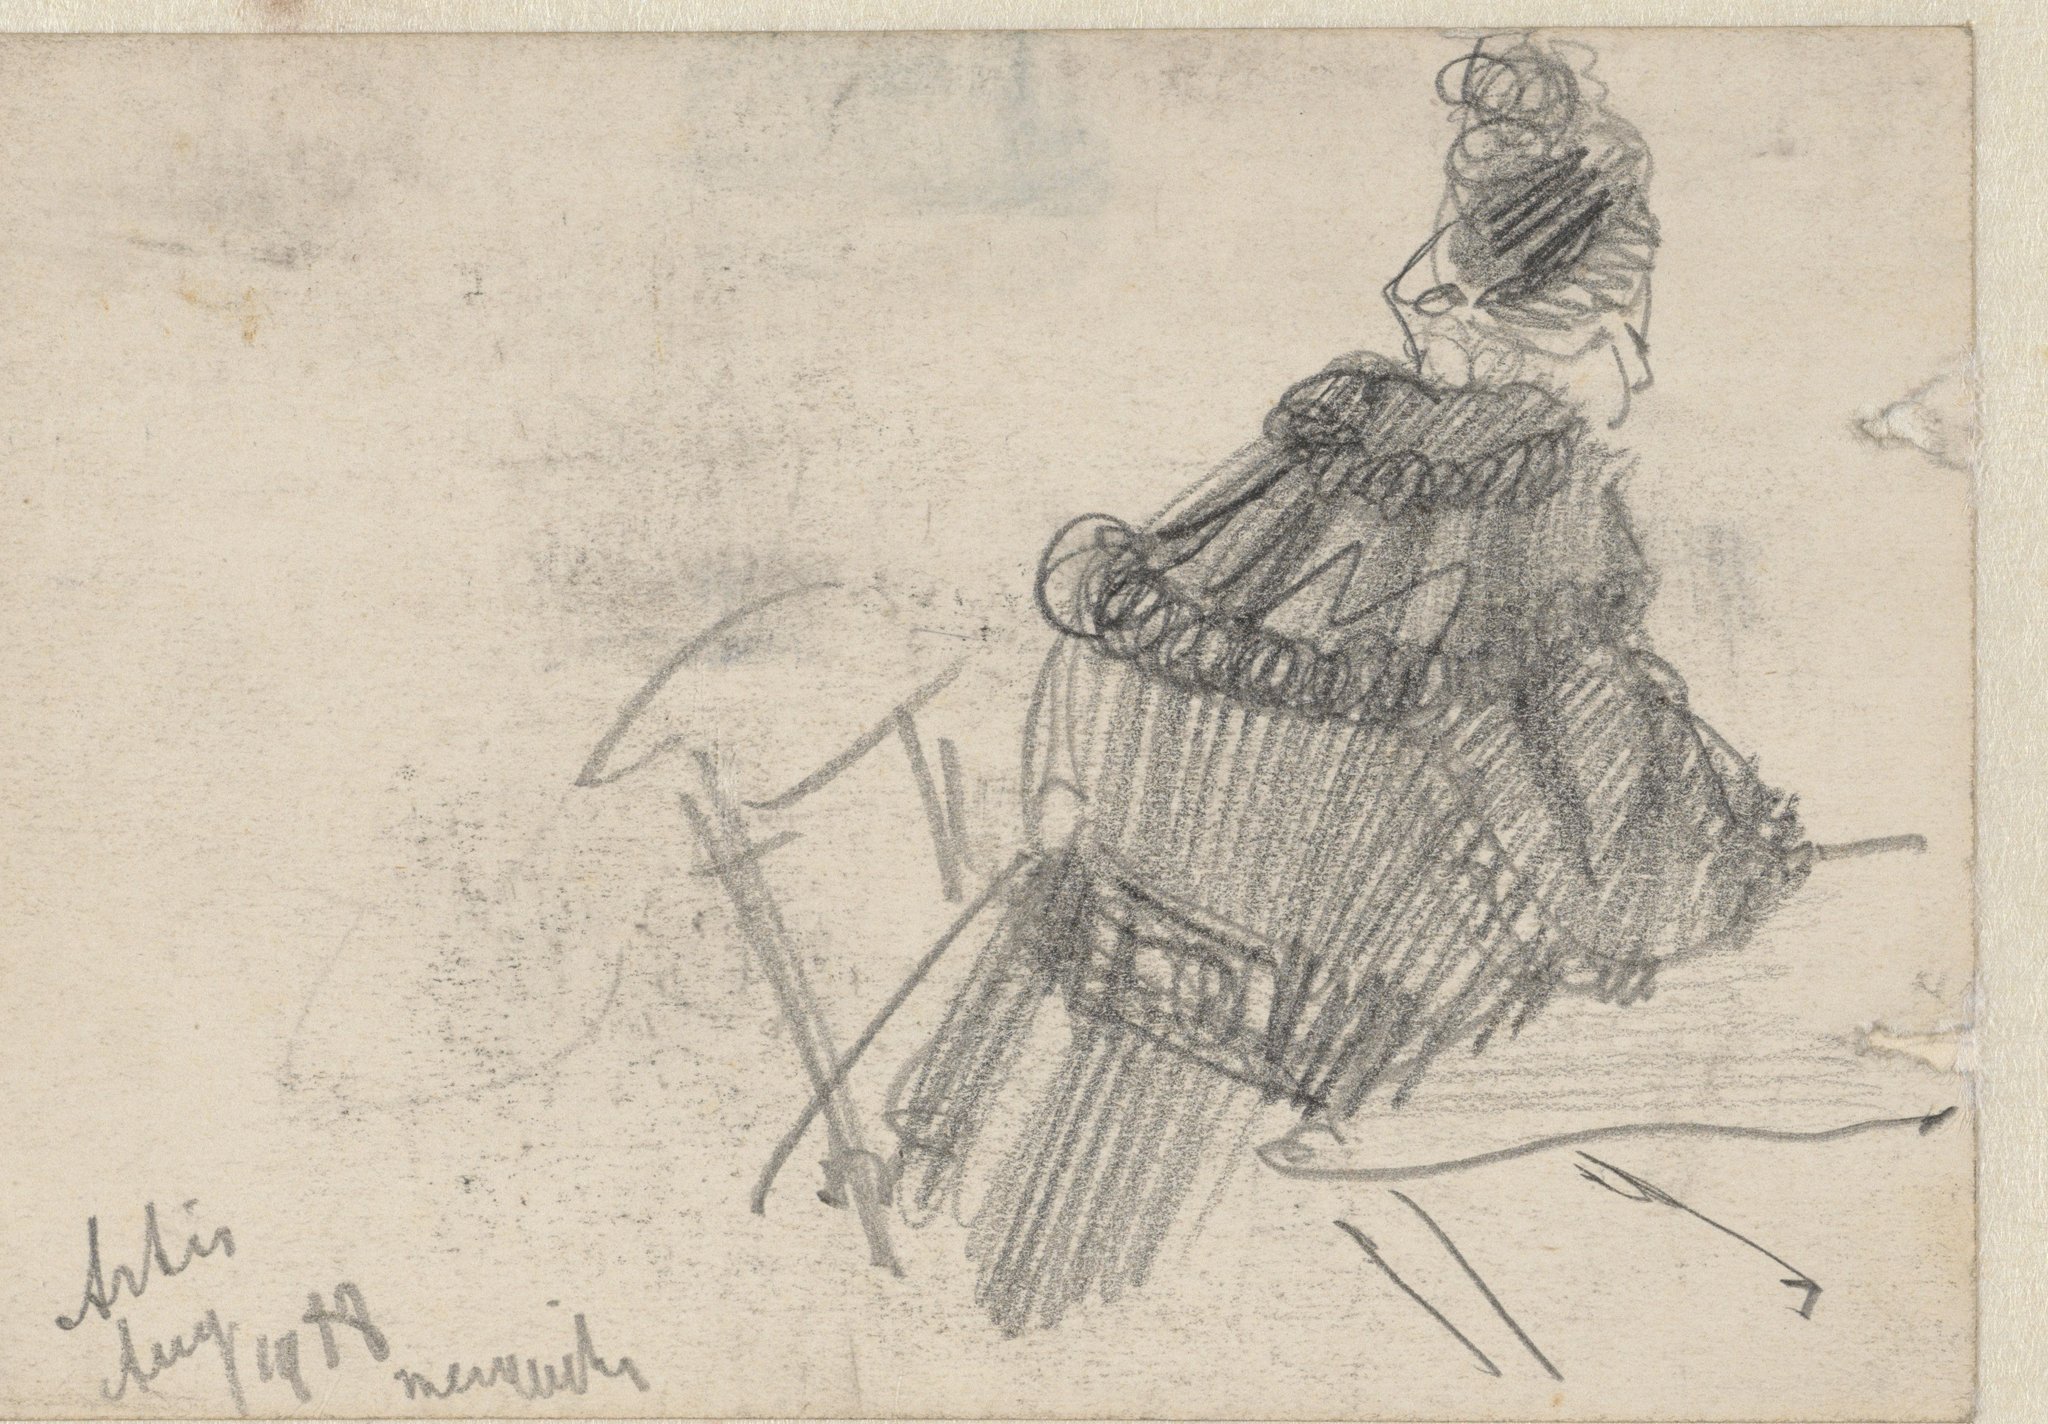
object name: drawing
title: Zittende oude vrouw aan een tafel te Artis, op de rug gezien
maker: samuel jessurun de mesquita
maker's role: draughtsman, print maker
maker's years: 1868-1944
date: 1908-1918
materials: paper, pencil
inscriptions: date: ‘Aug. 1918’